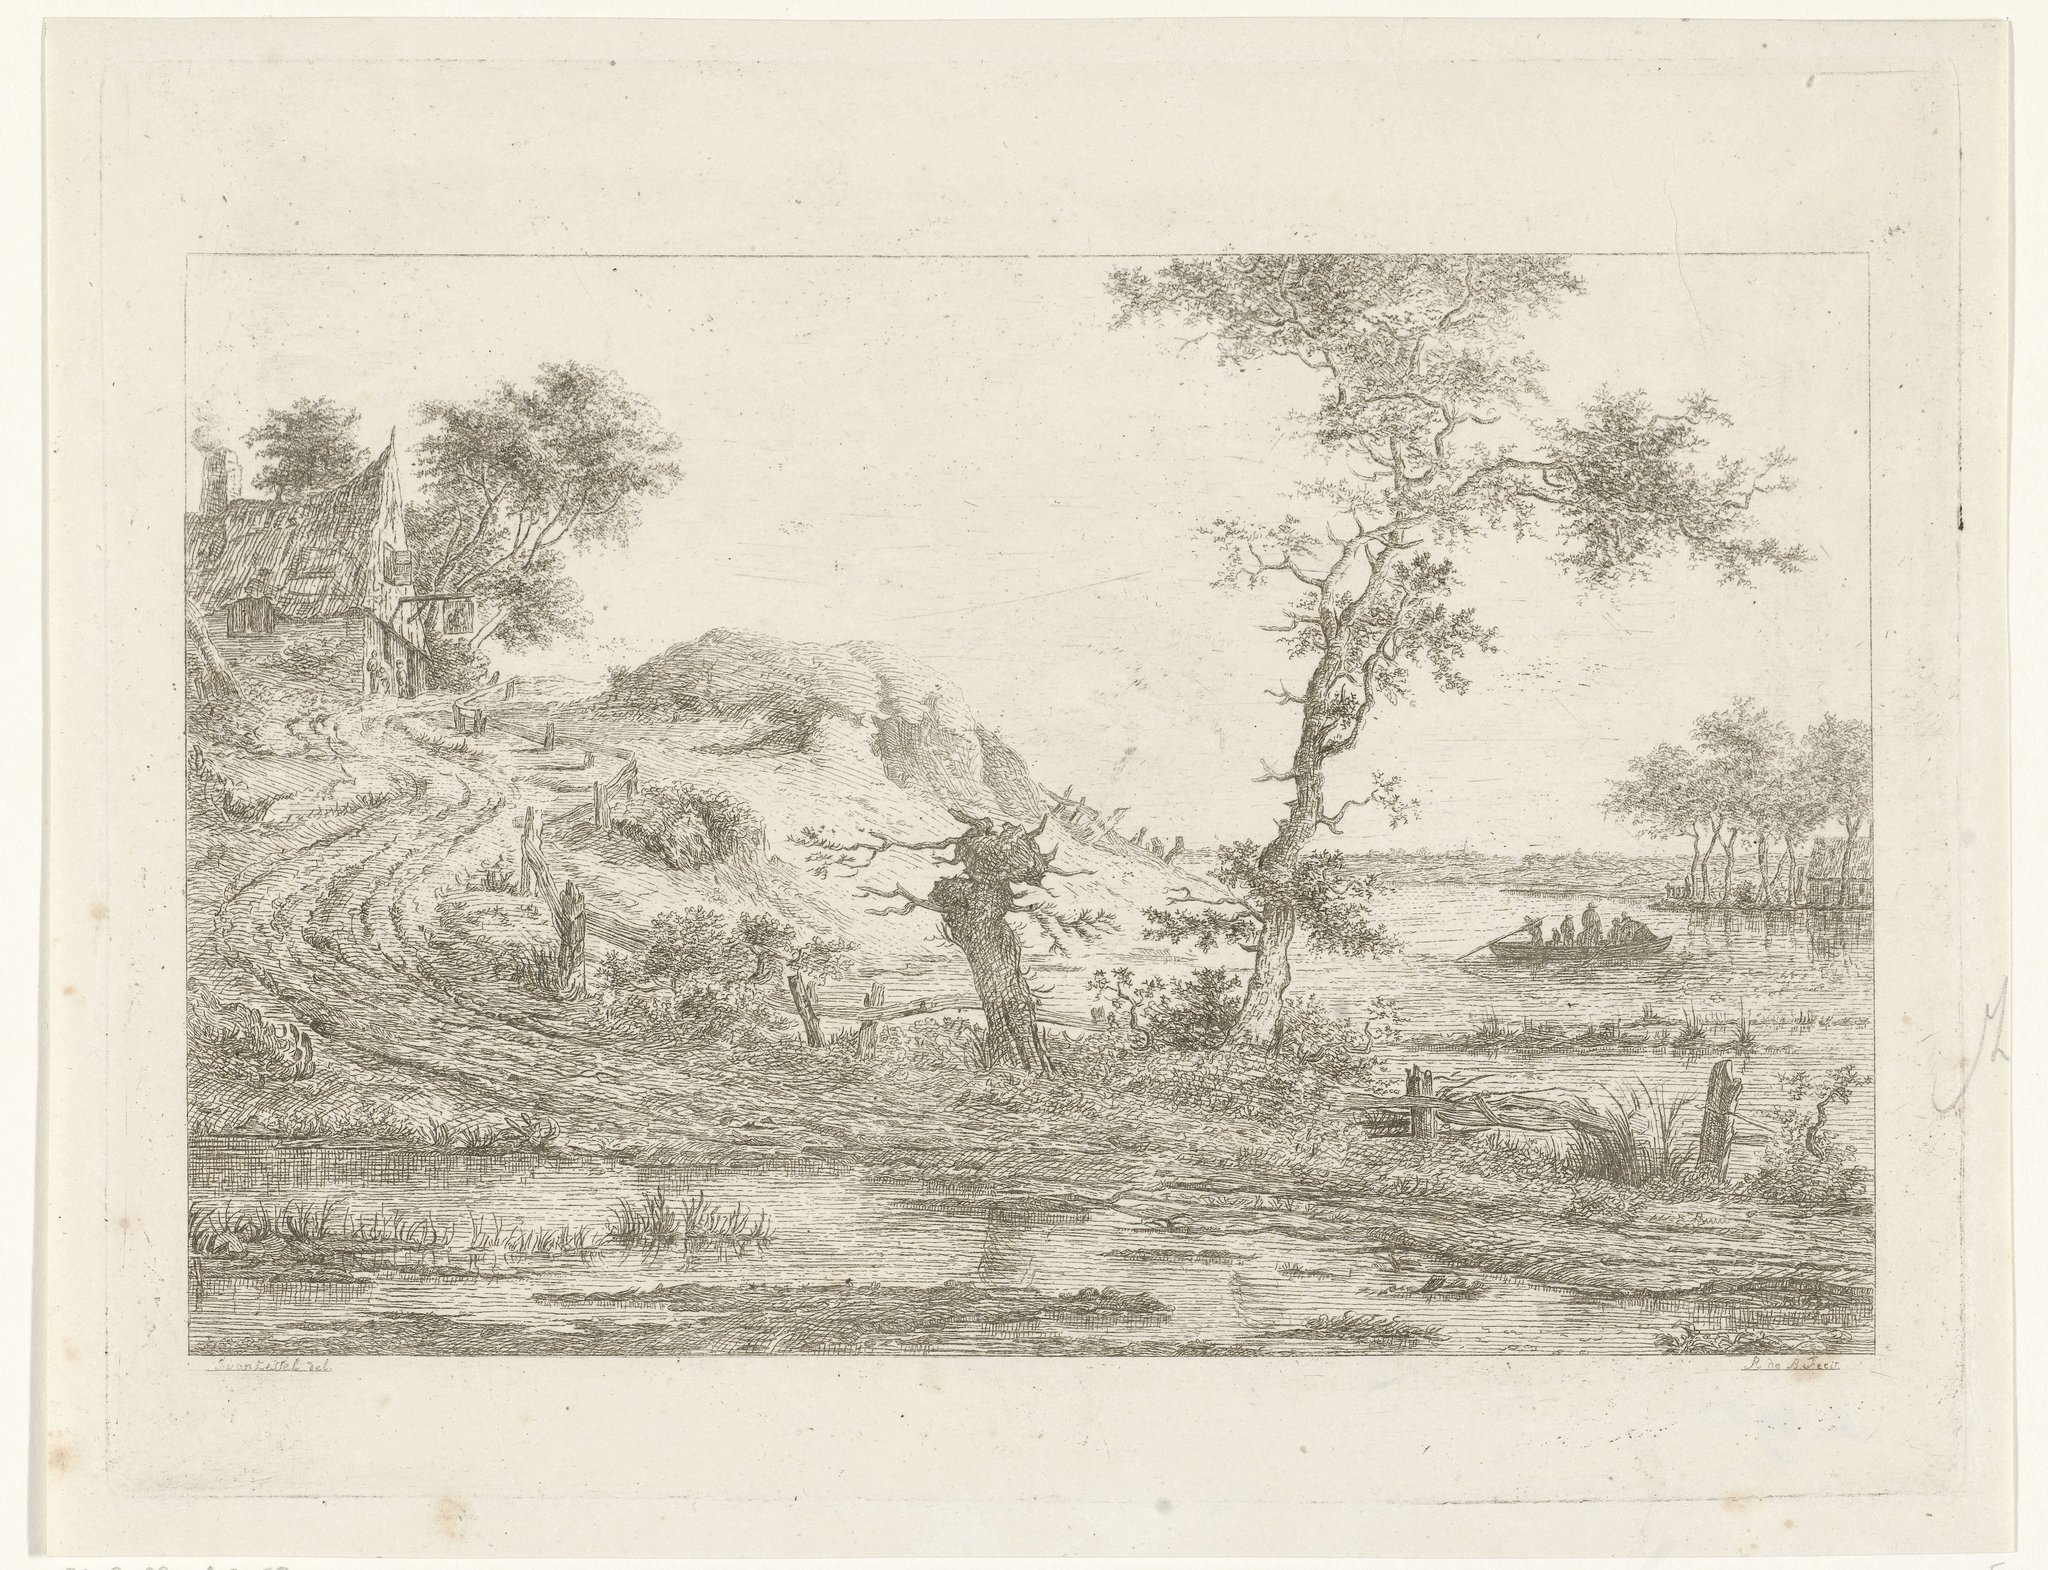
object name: print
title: Huis op een heuvel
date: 1796-1856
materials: paper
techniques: etching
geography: vaassen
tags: inn, coffee-house, public house, etc., rowing-boat, canoe, etc.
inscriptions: collector's mark: Lugt 2228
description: Een weg leidt naar een uitspanning met een uithangbord links op de heuvel. Rechts op het water vaart een schuit met passagiers.